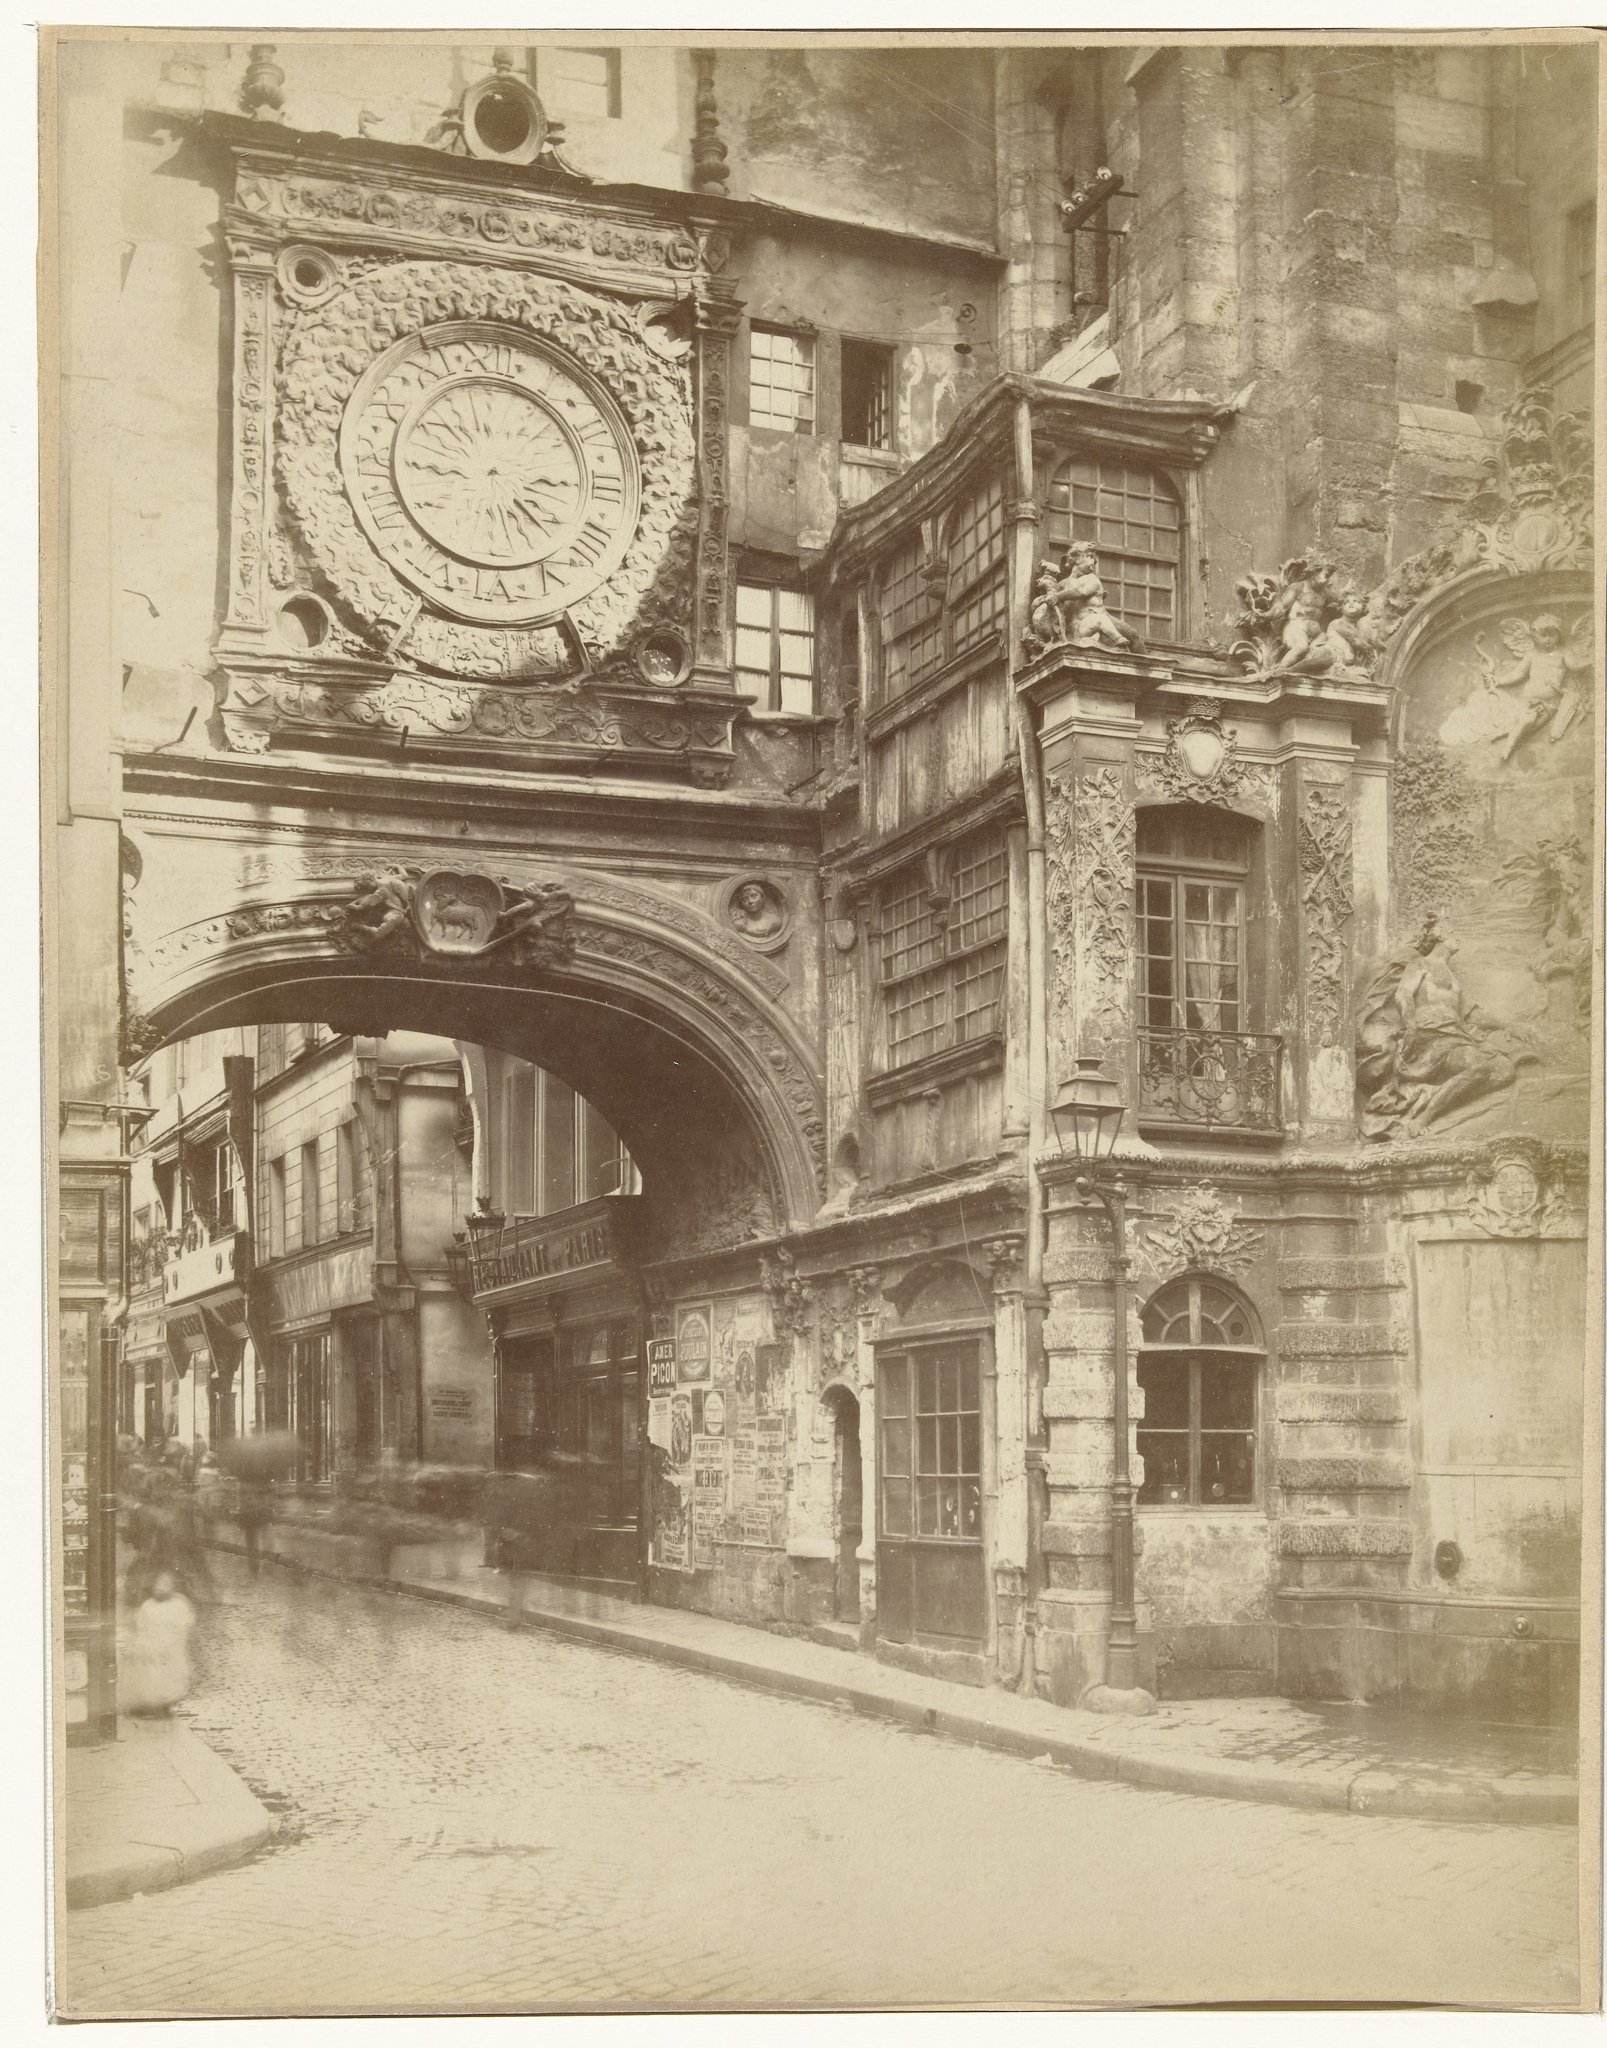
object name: photograph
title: Gezicht op de Rue du Gros-Horloge in Rouen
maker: Anonymous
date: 1860-1900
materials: cardboard, paper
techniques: albumen print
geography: rouen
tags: clock, street